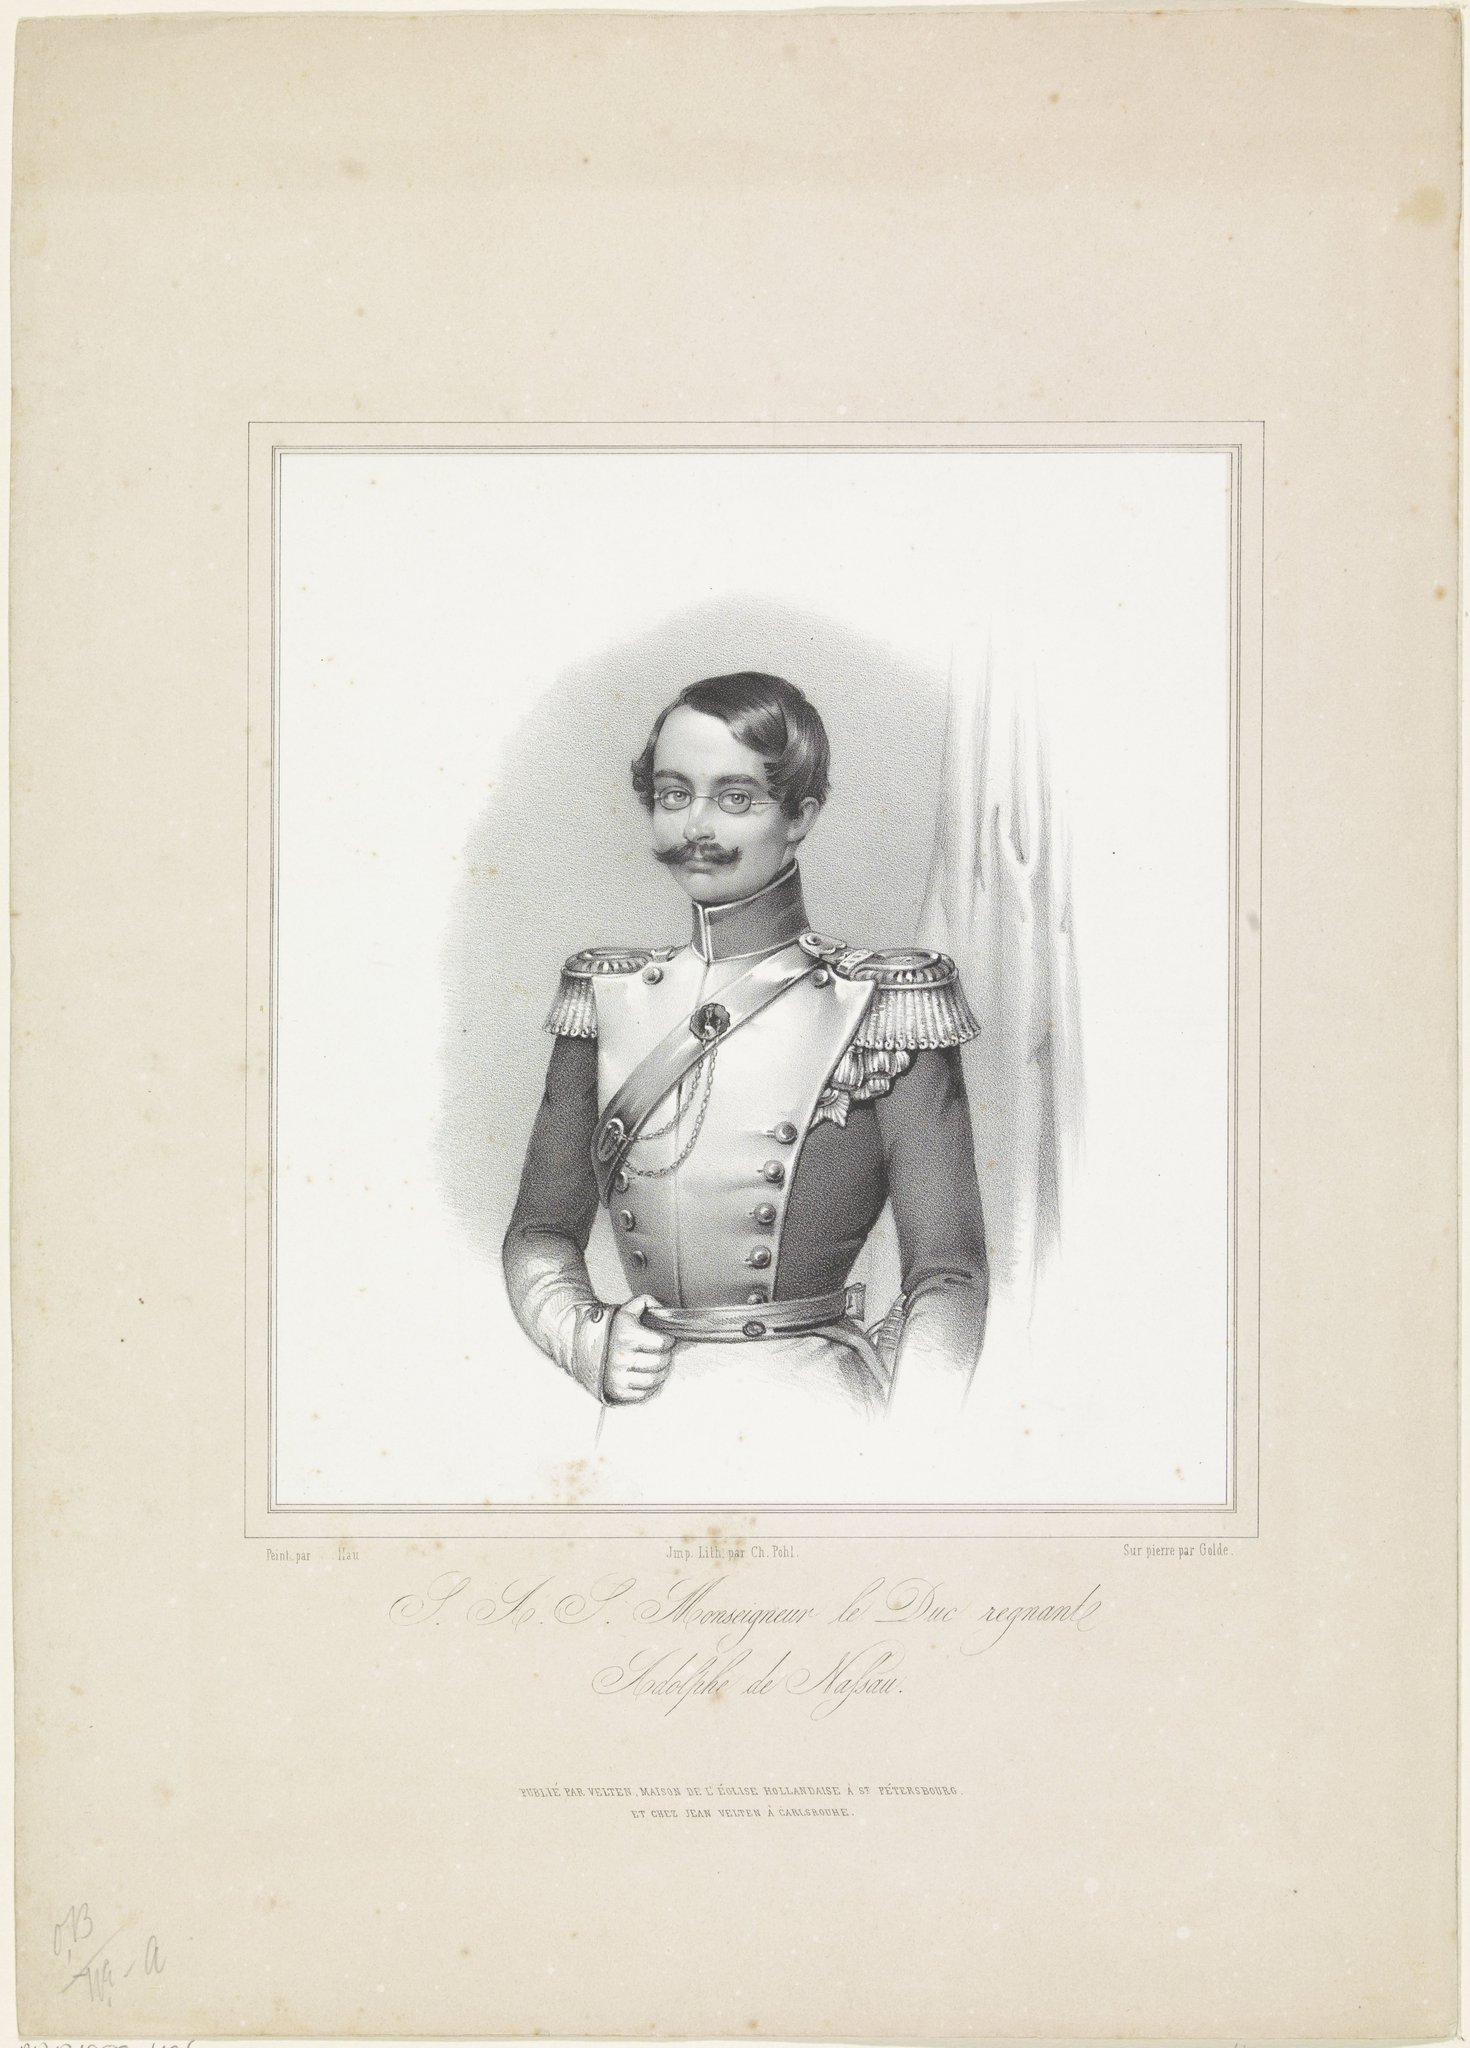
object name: print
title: Portret van Adolf van Nassau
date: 1835-1899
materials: paper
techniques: lithograph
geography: karlsruhe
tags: adolf van nassau, huis nassau walramse linie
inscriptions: collector's mark: Lugt 2228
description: Portret van Adolf. In de ondermarge zijn naam en titel.